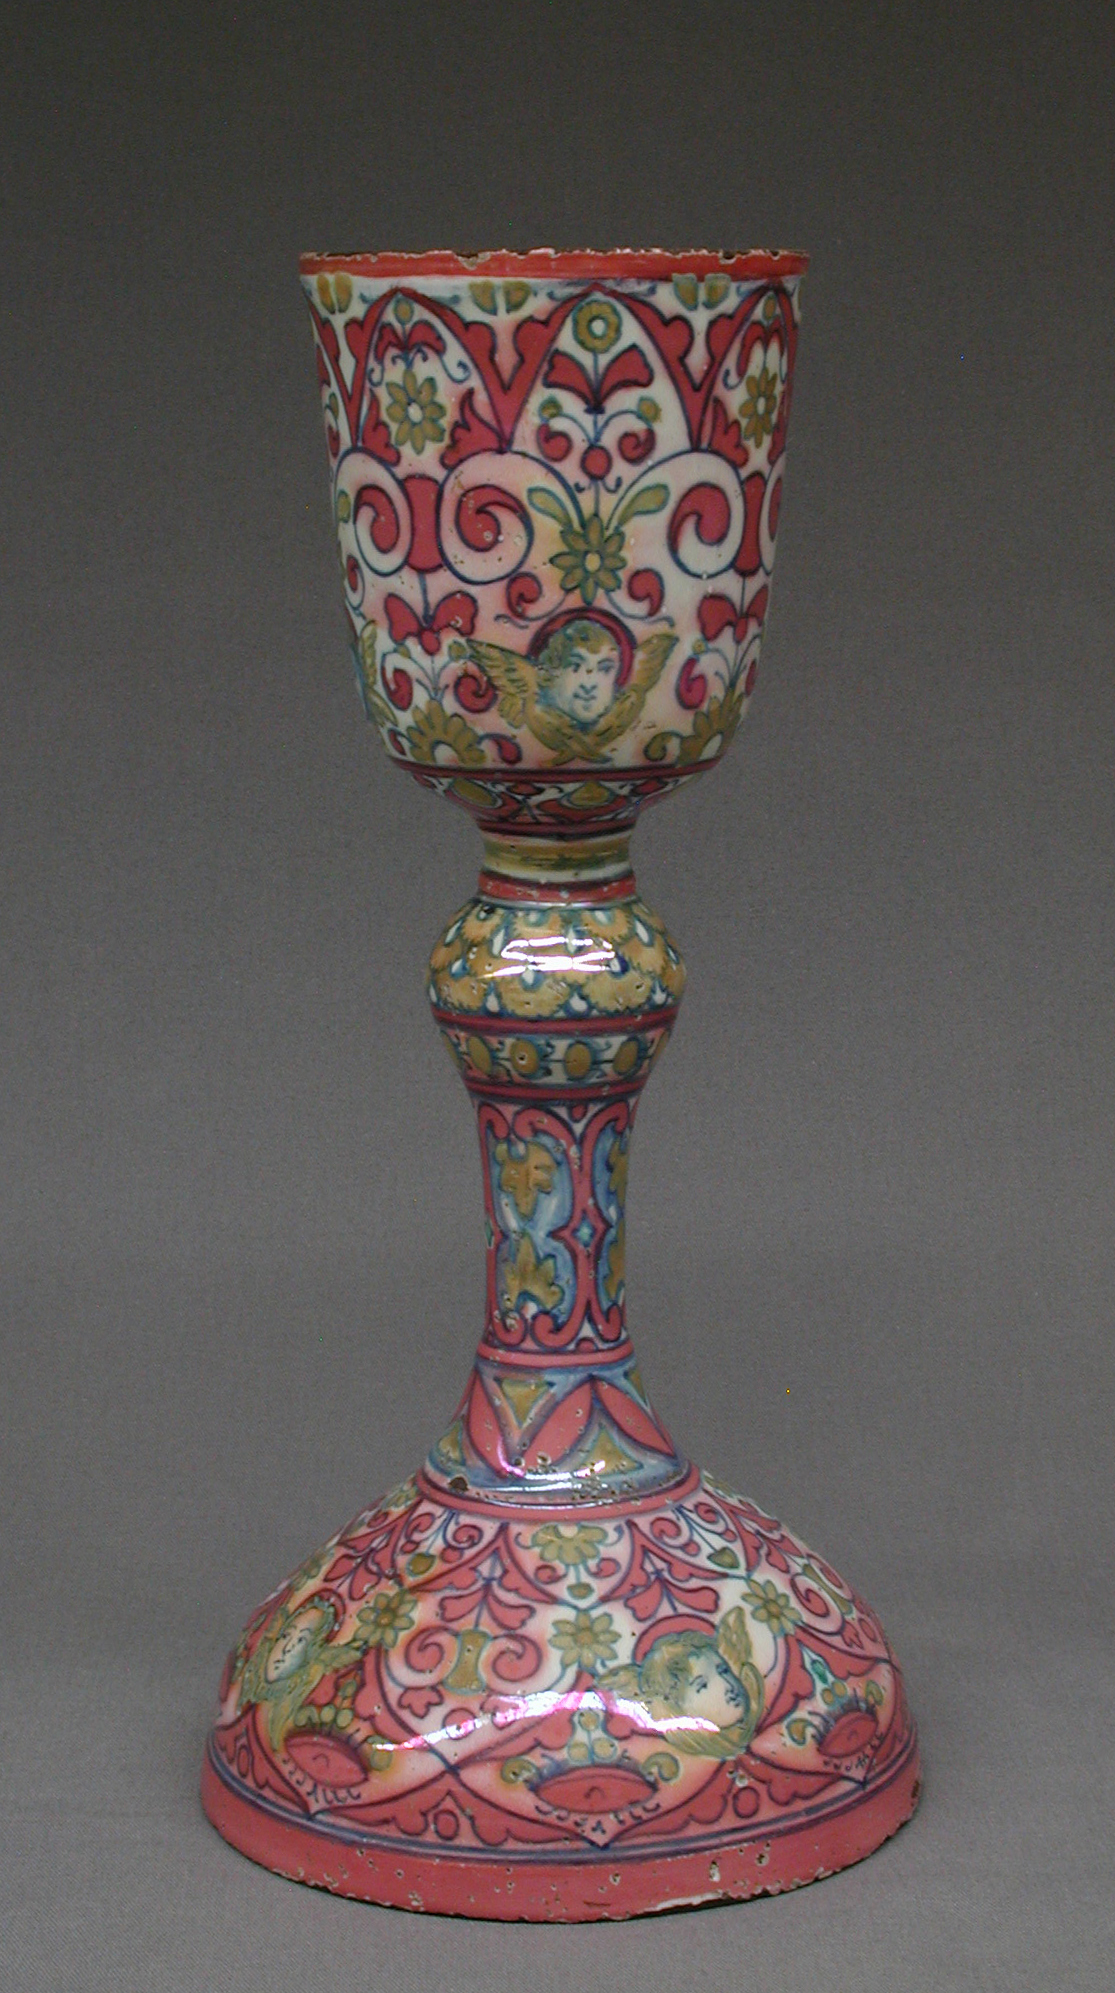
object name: standing cup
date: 1801-1900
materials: earthenware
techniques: glazing